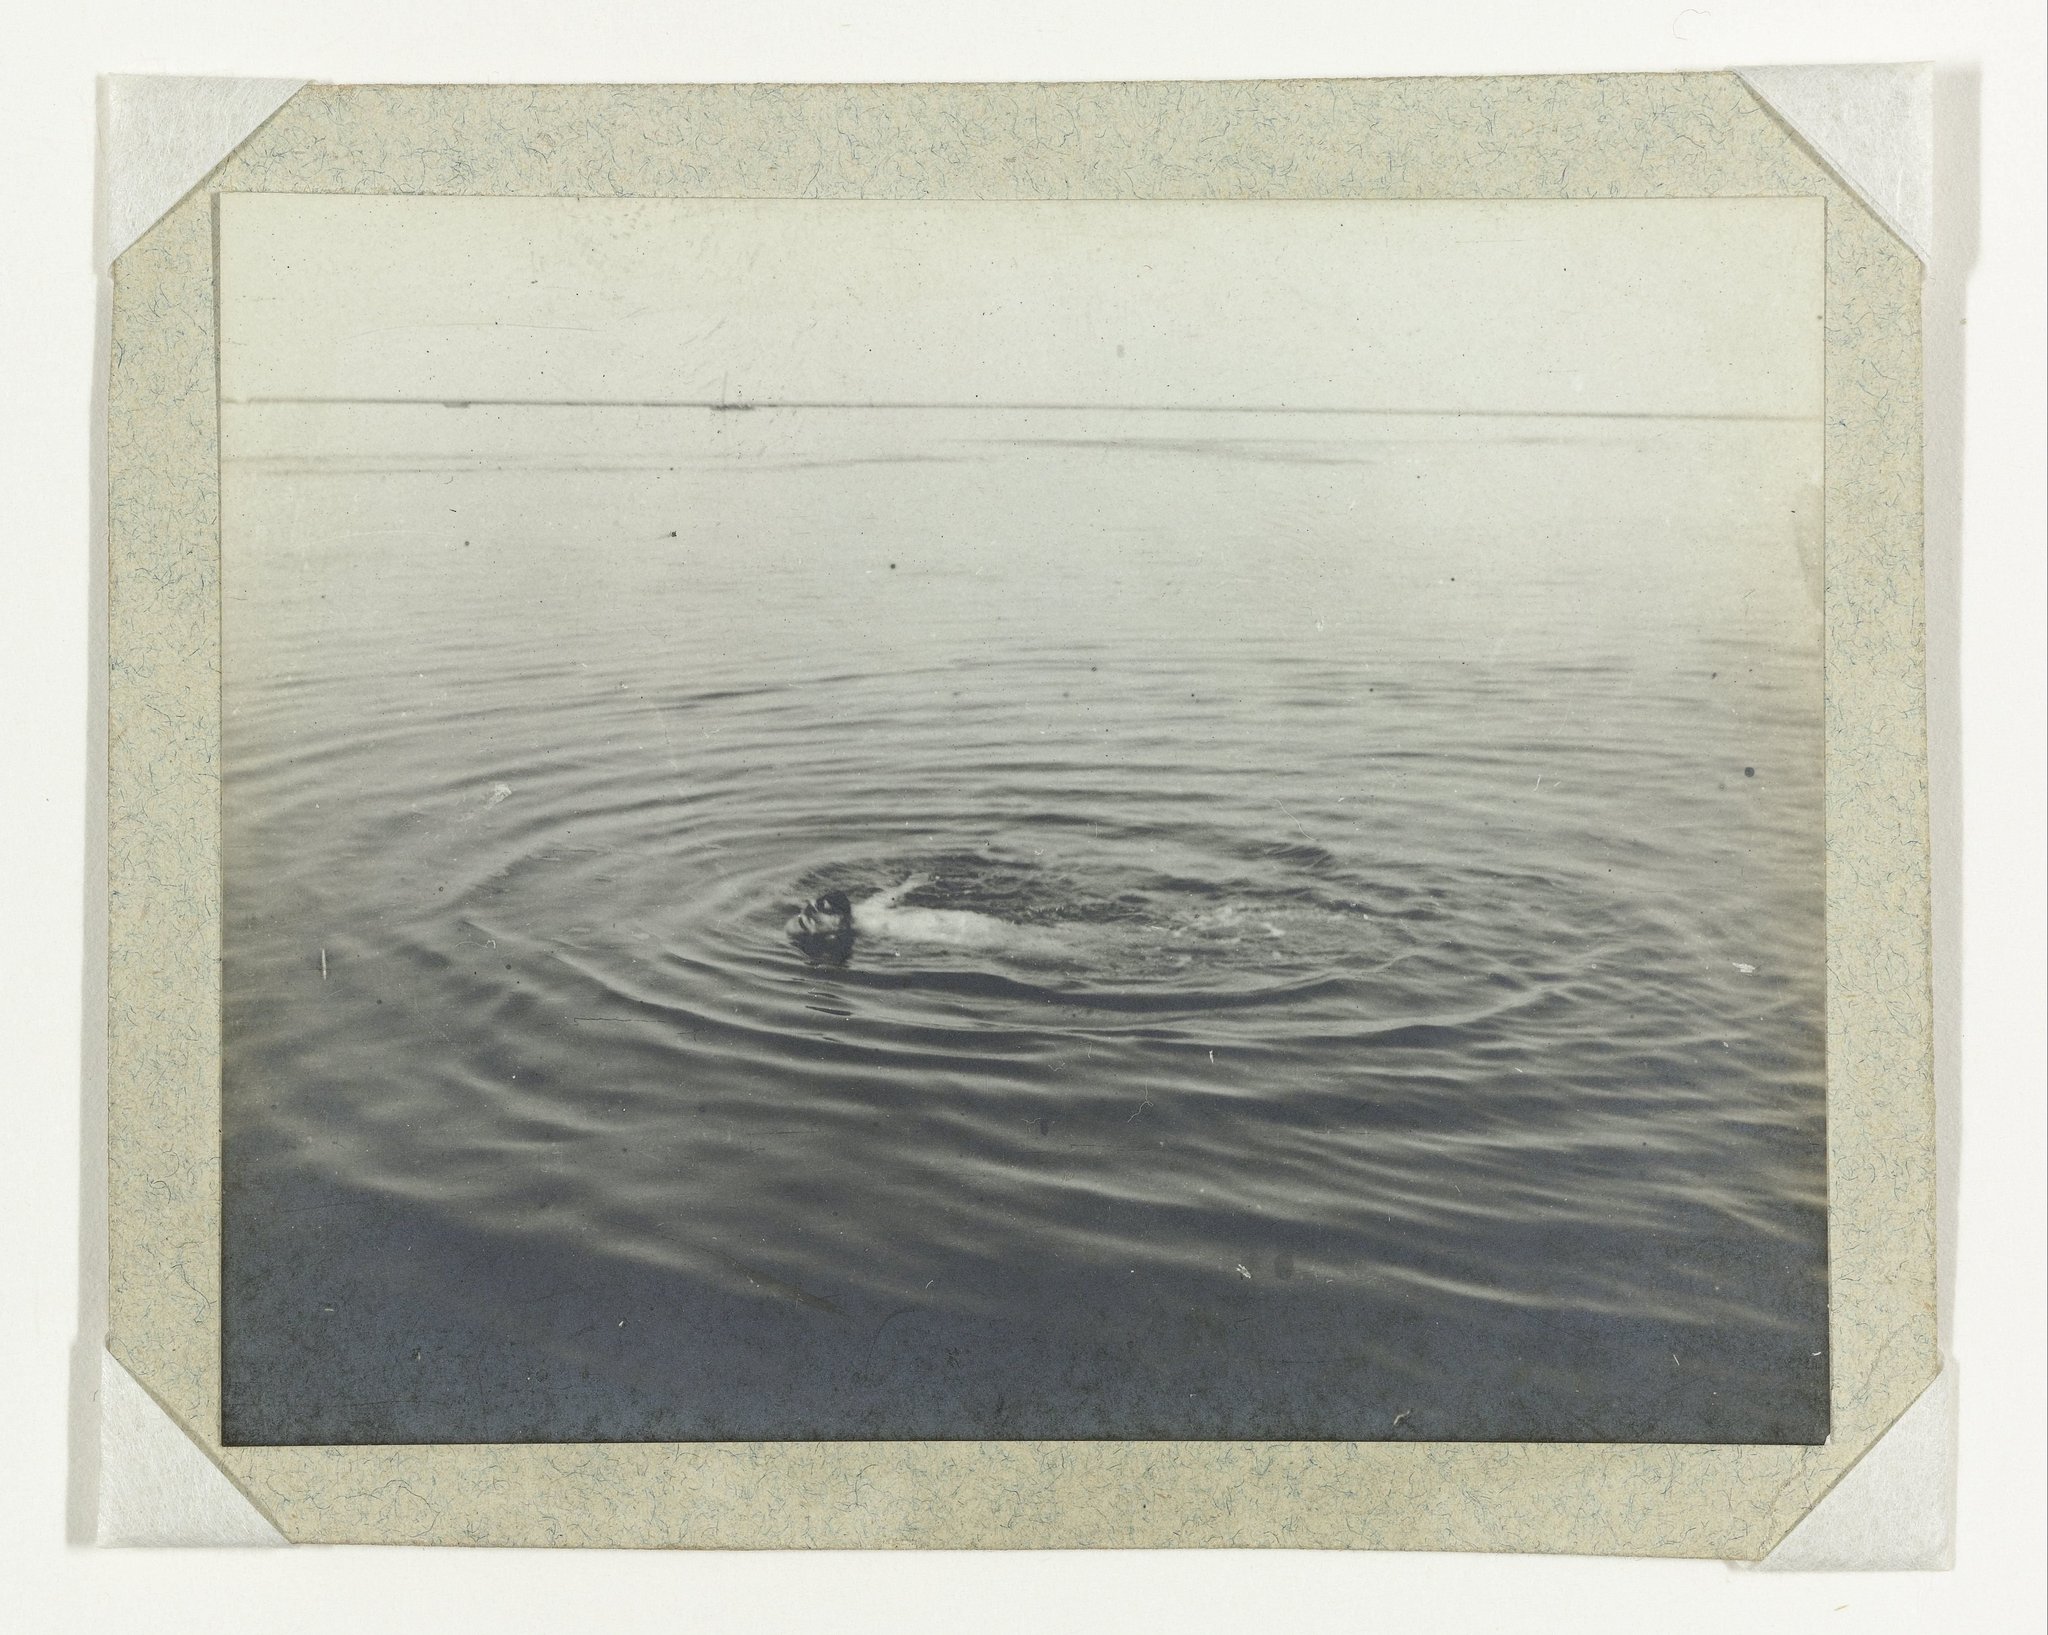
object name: photograph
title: Toulouse-Lautrec Swimming in the Bassin d’Arcachon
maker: maurice guibert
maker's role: fotograaf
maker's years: 1856-1913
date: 1896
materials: paper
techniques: gelatin silver print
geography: bassin d'arcachon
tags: draughtsman, henri de toulouse-lautrec, swimming (sport), artist in non-work situation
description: A swimming party, picnic, or holiday adventure were new subjects in photography around 1900. Amateurs began recording daily life and primarily leisure time with small and easy-to-use cameras in rapid – and sometimes inept – snapshots. The dot in this photograph is the famous painter Henri de Toulouse-Lautrec. His friend Maurice, an amateur photographer, captured the artist while taking a summertime dip in the sea near Bordeaux.